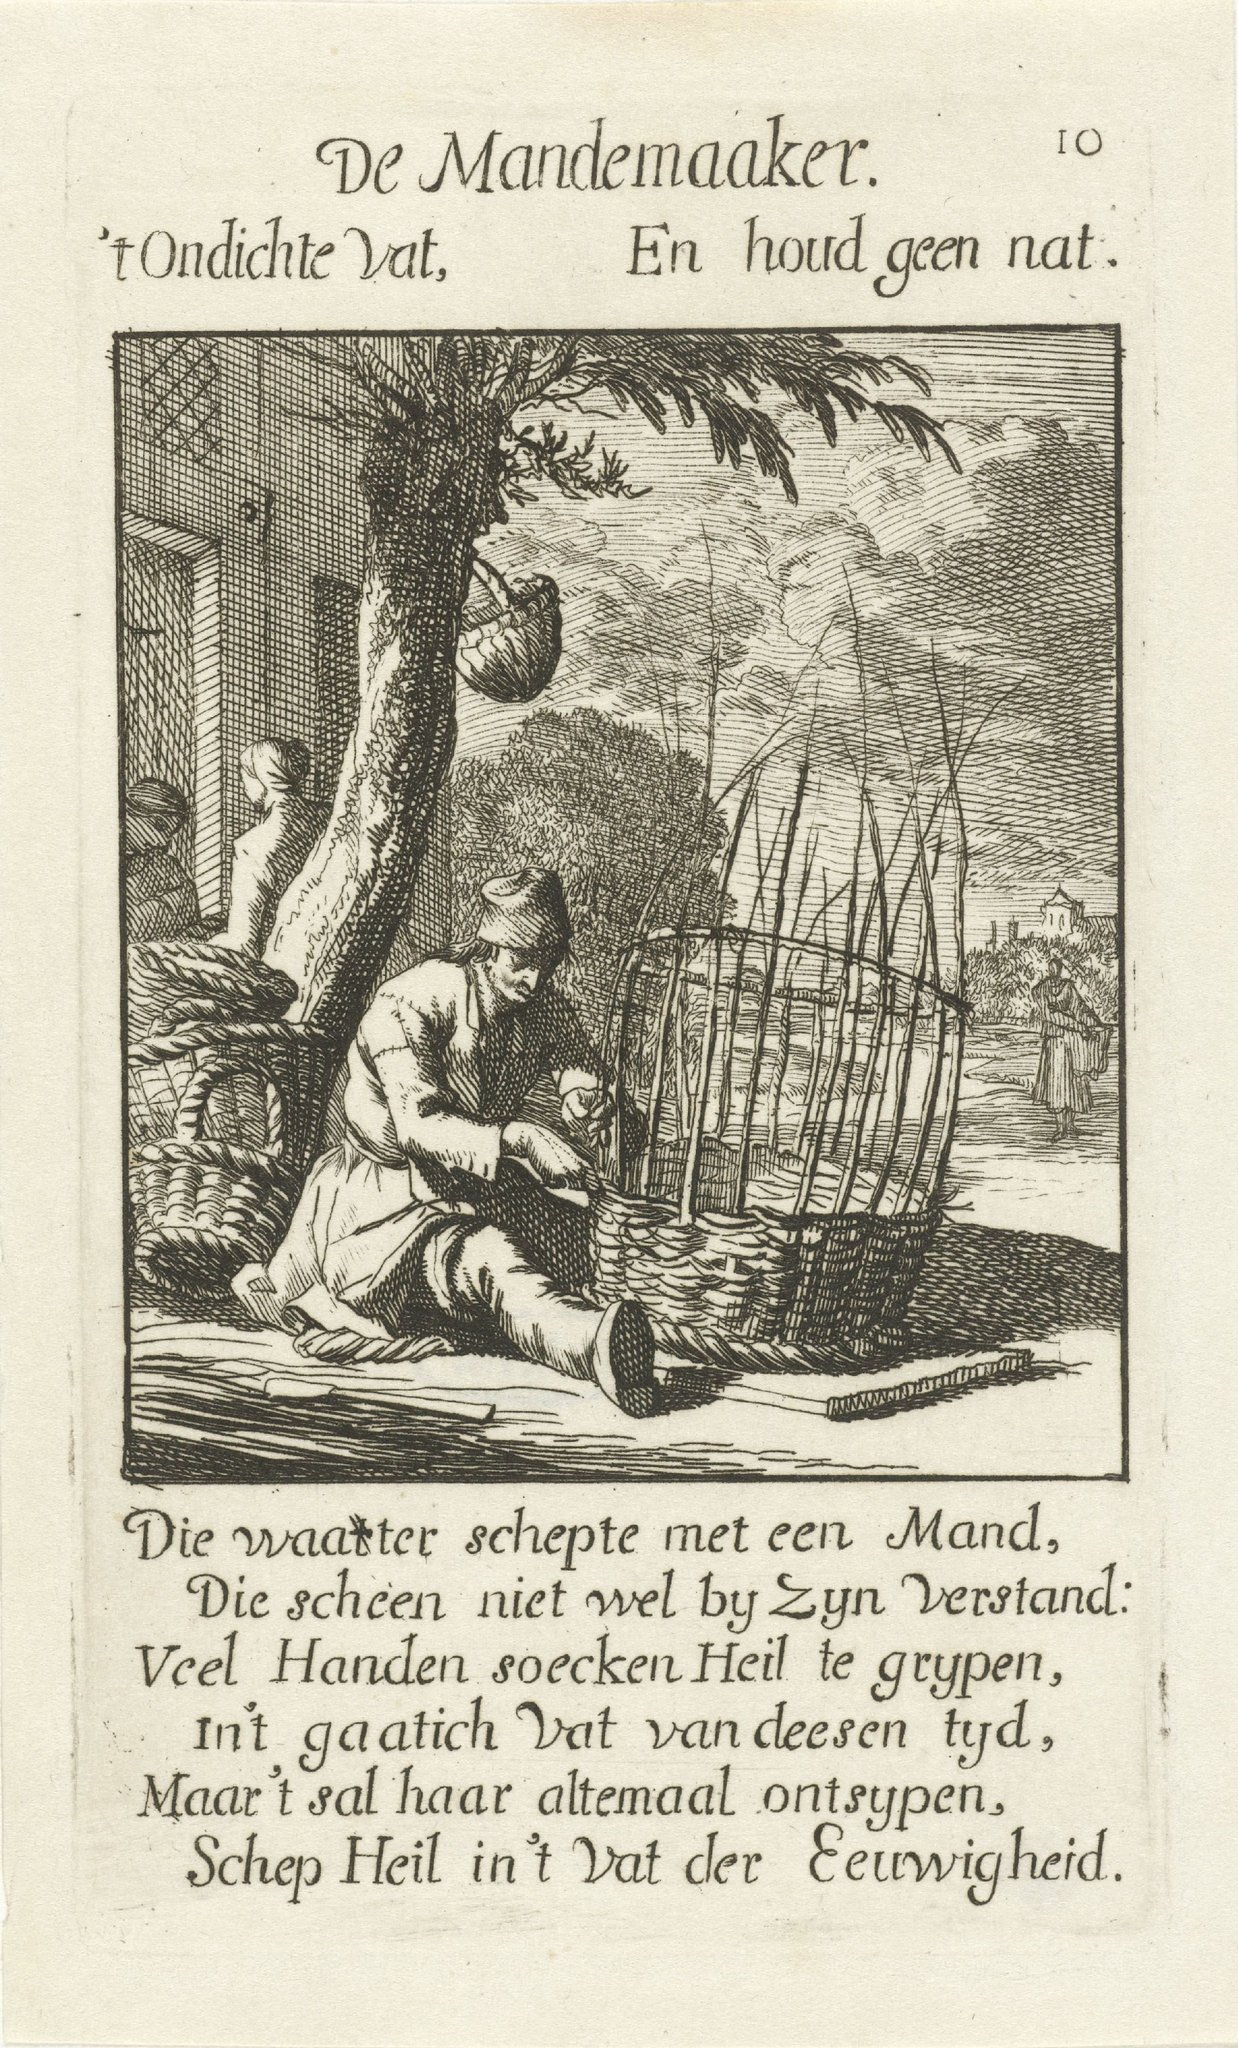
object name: print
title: Mandenmaker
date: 1694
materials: paper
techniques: etching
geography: amsterdam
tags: handicrafts, craftsman at work, container made of plant material other than wood: basket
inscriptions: collector's mark: Lugt 2760, collector's mark: Lugt 2228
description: Maakt deel uit van de 100-delige serie beroepsprenten van Jan en Caspar Luyken, getiteld: Het menselyk bedryf. S.l.s.n., 1694 (eerste druk).